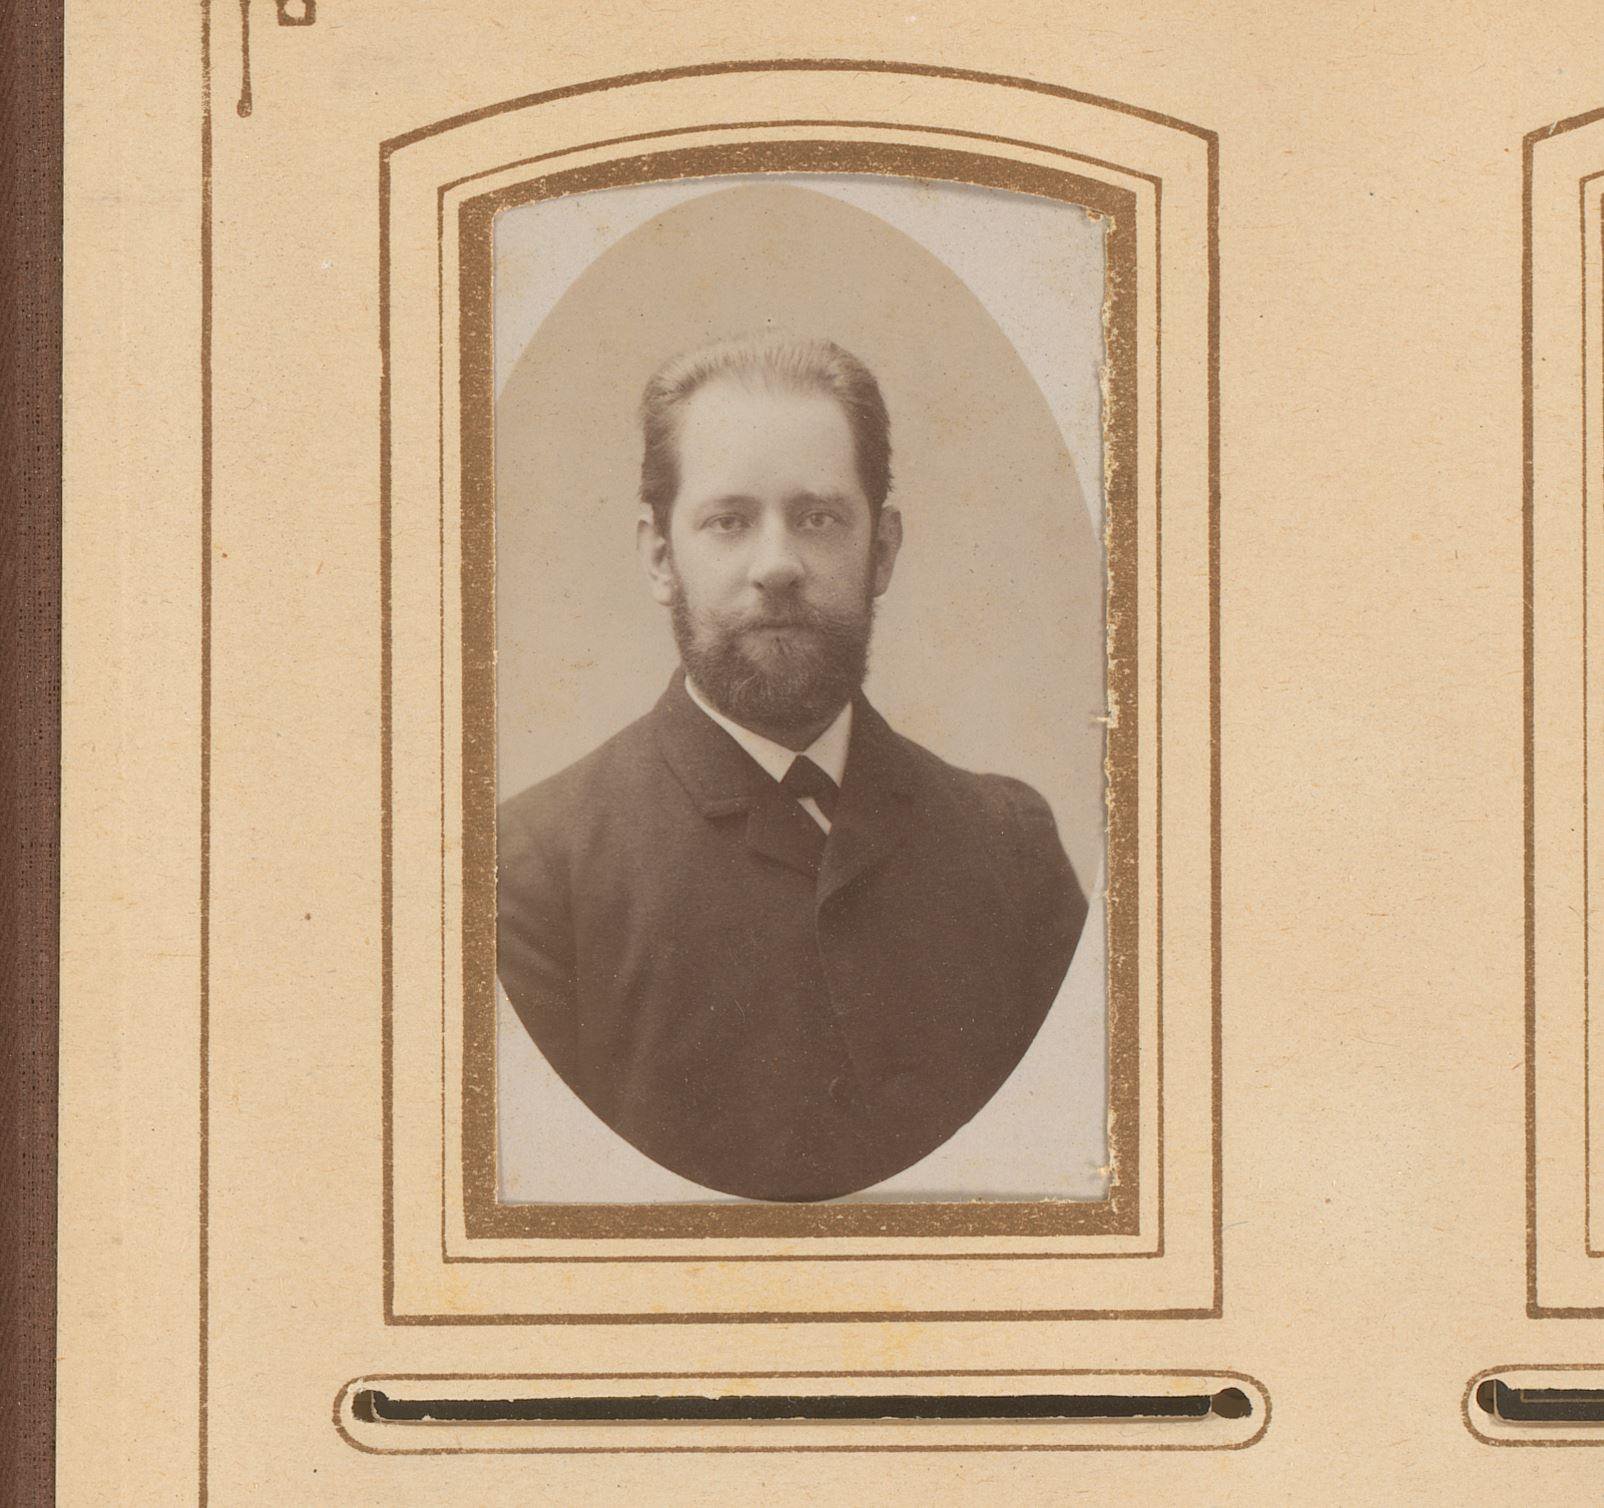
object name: carte de visite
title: Portret van een man met baard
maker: johannes leonardus van der heijden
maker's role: fotograaf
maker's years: 1856-1937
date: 1875-1915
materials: cardboard, photographic support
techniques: albumen print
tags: adult man, historical persons, beard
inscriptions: inscription: ‘Johs L. v.d. Heyden/ Amsterdam Singel 435.’